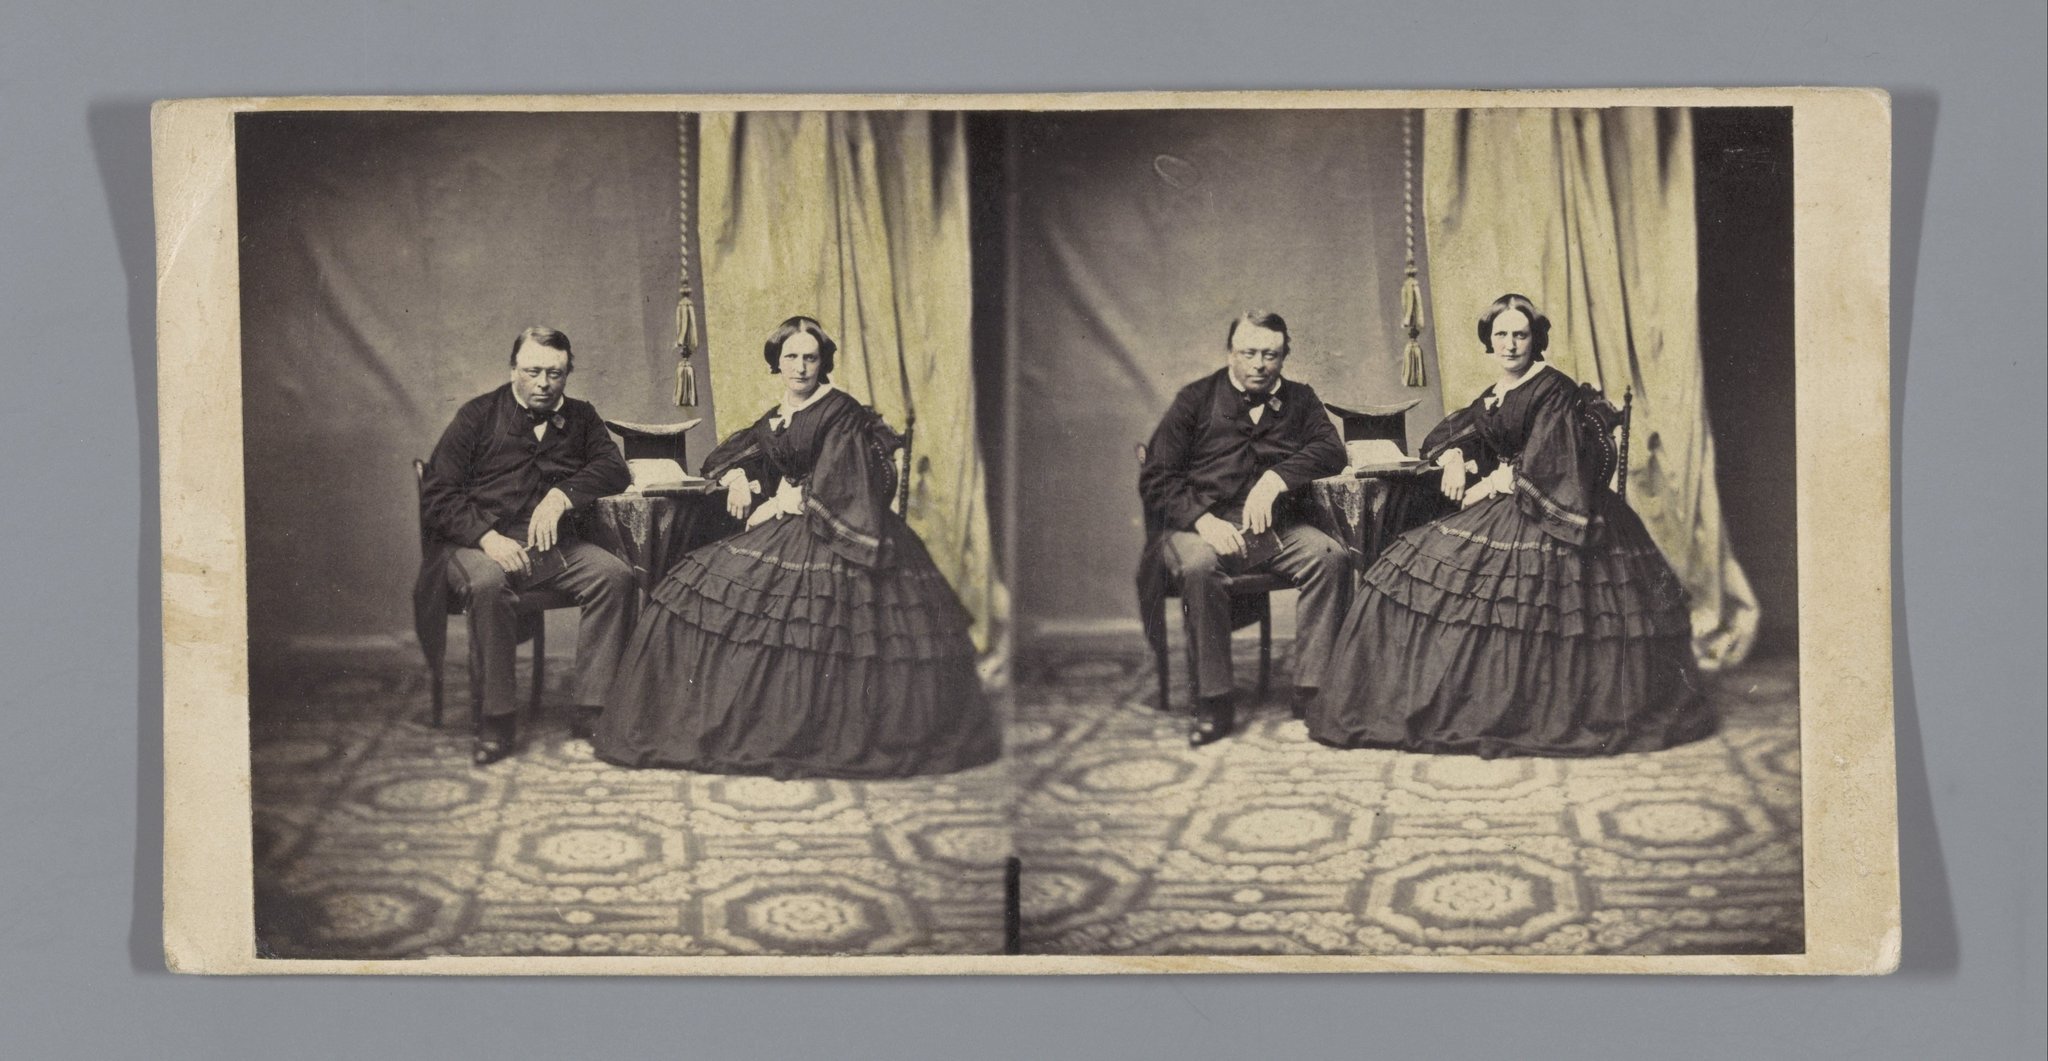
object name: stereograph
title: Portret van een man en een vrouw aan een tafel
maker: Anonymous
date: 1850-1880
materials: cardboard, photographic support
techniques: albumen print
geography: europe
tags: sitting figure, europe